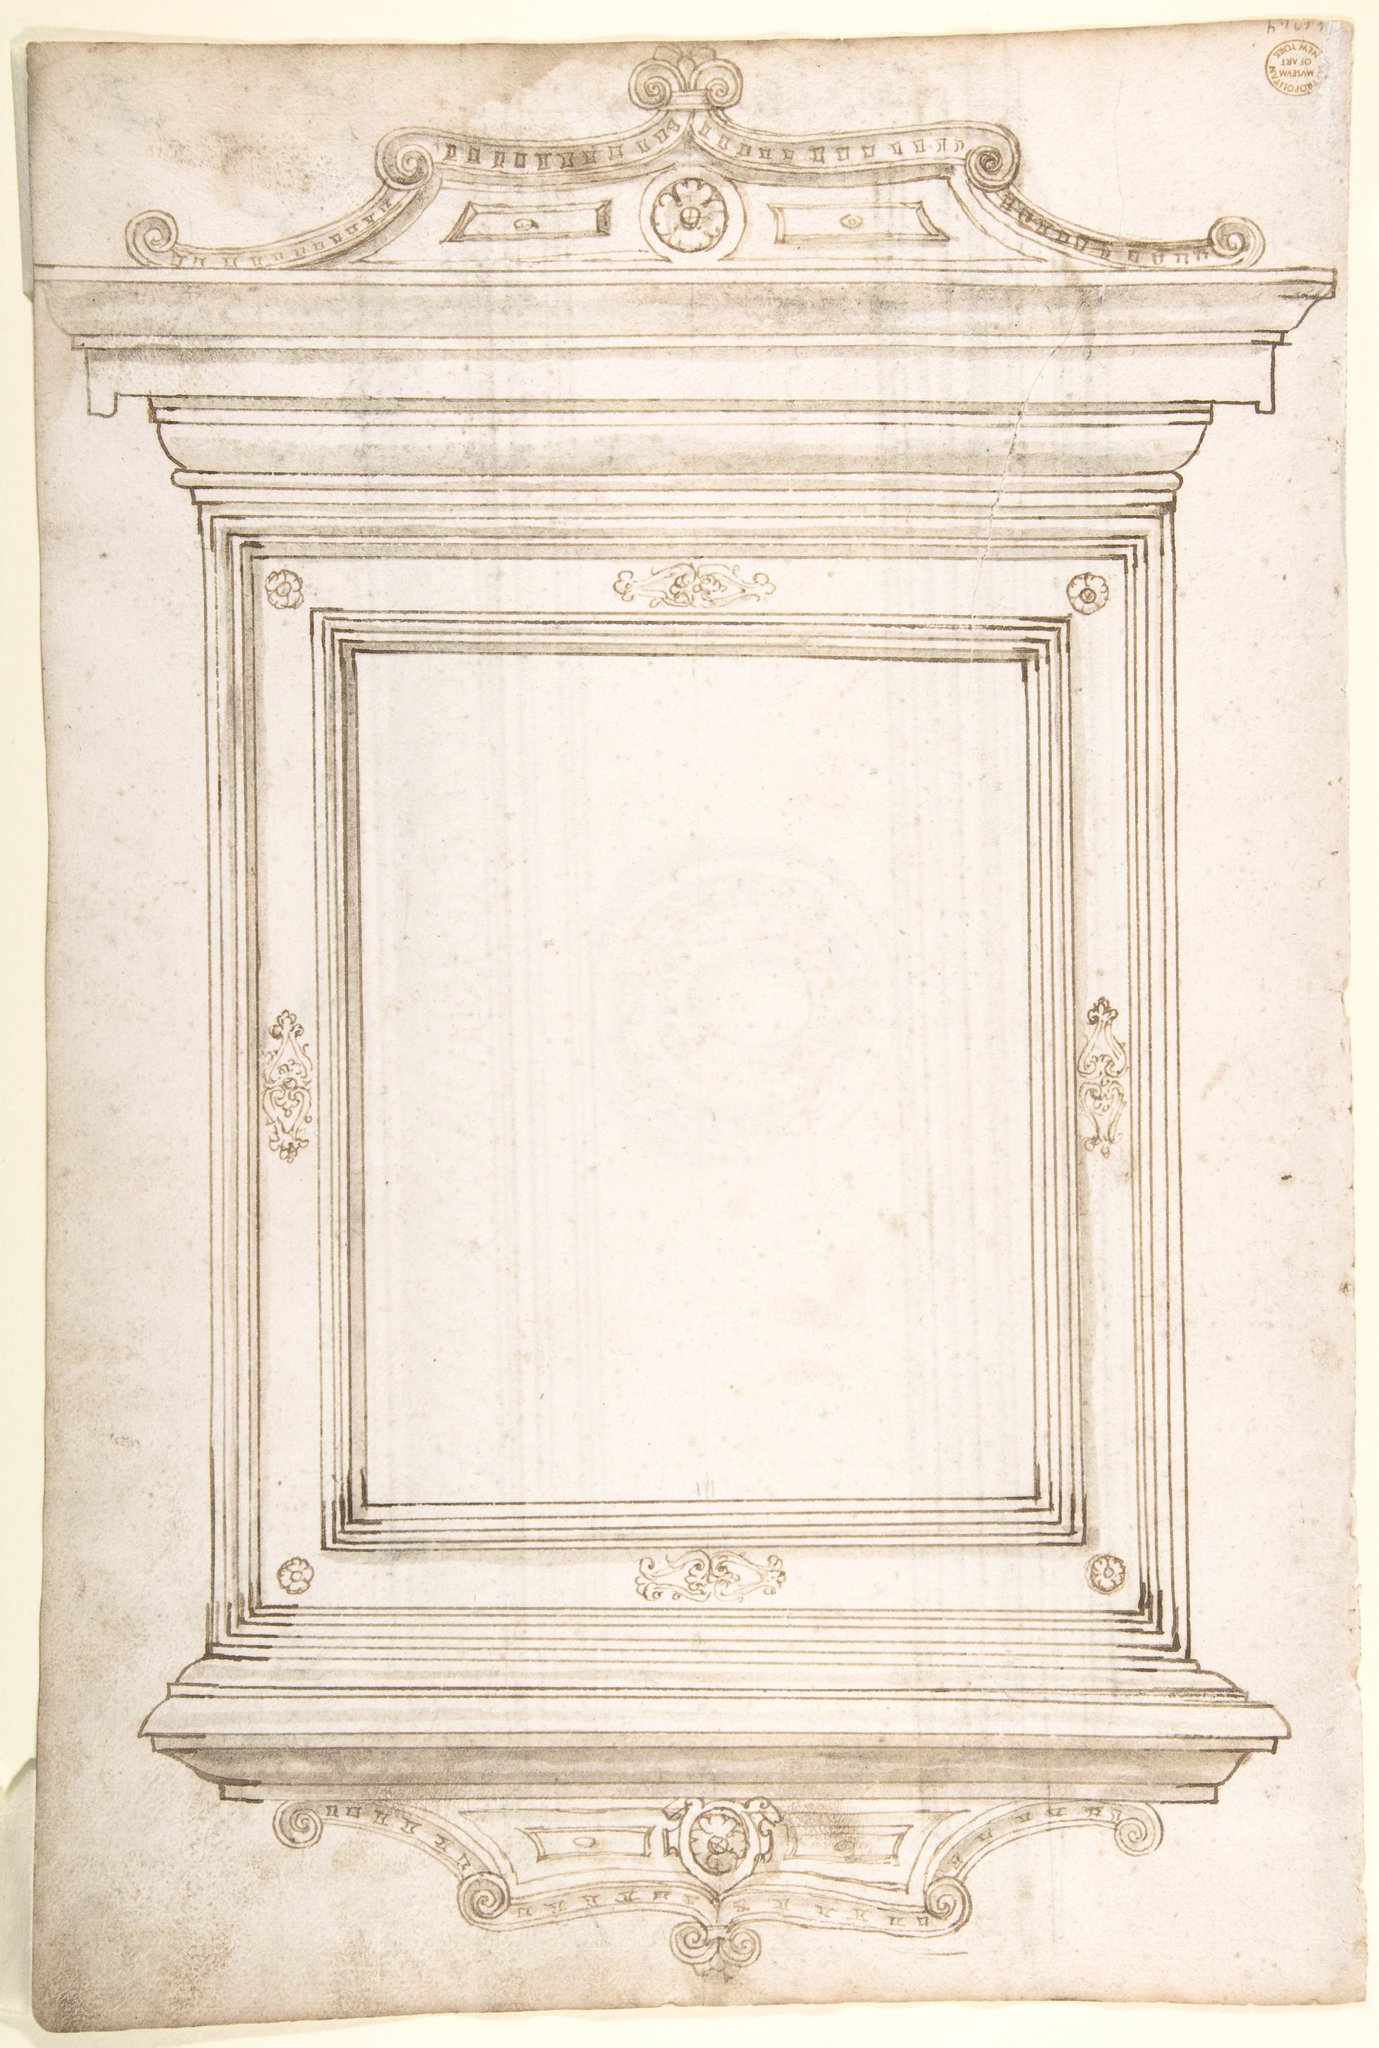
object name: drawing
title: Design for a Frame (recto); Design for a Cassone (verso)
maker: anonymous, italian, 16th century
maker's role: artist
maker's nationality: italian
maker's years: 1550-1600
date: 1501-1533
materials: ink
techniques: pen, wash